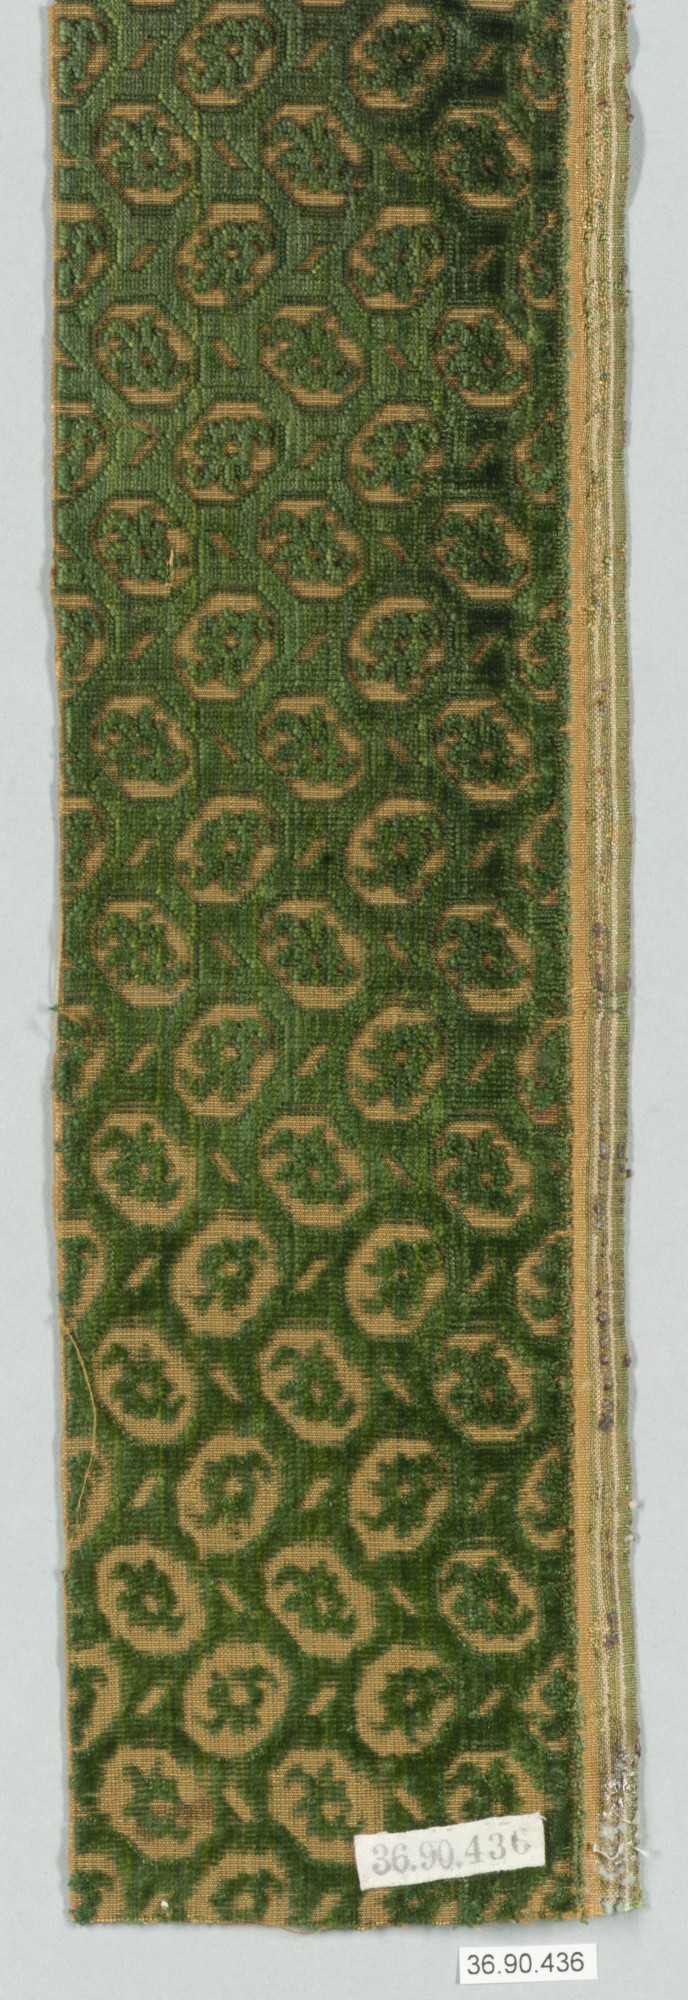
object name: piece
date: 1501-1700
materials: silk